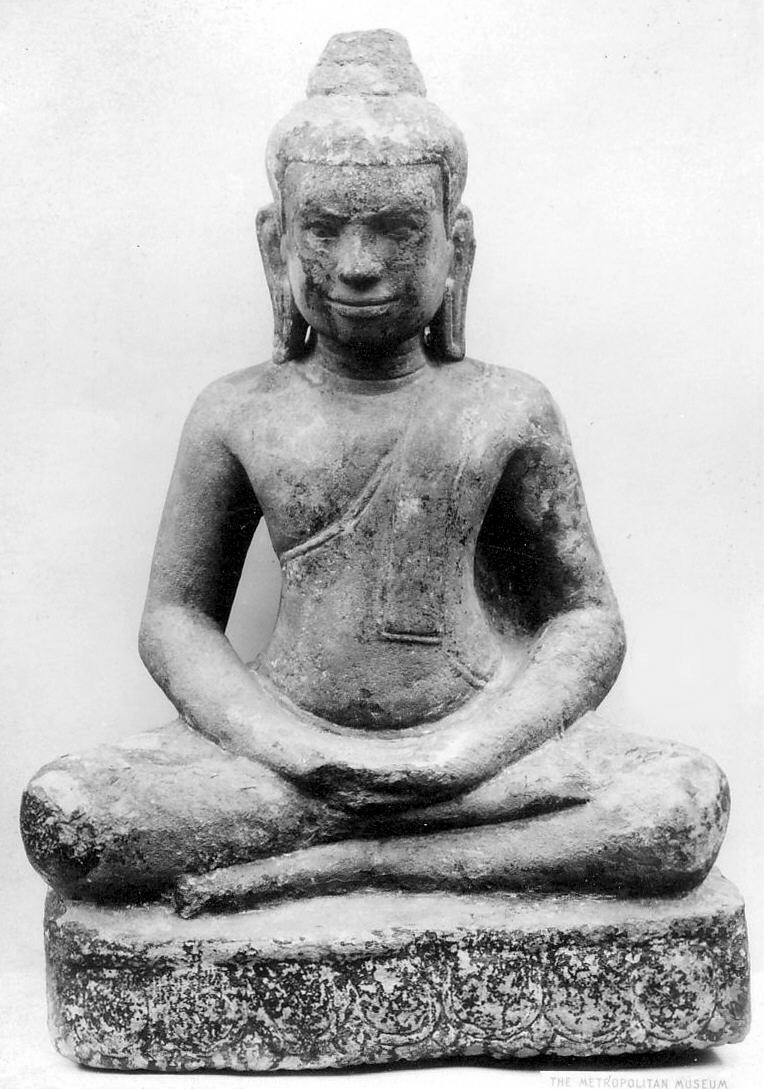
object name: statue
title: Seated Buddha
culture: cambodian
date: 801-1400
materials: stone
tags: buddhism,buddha